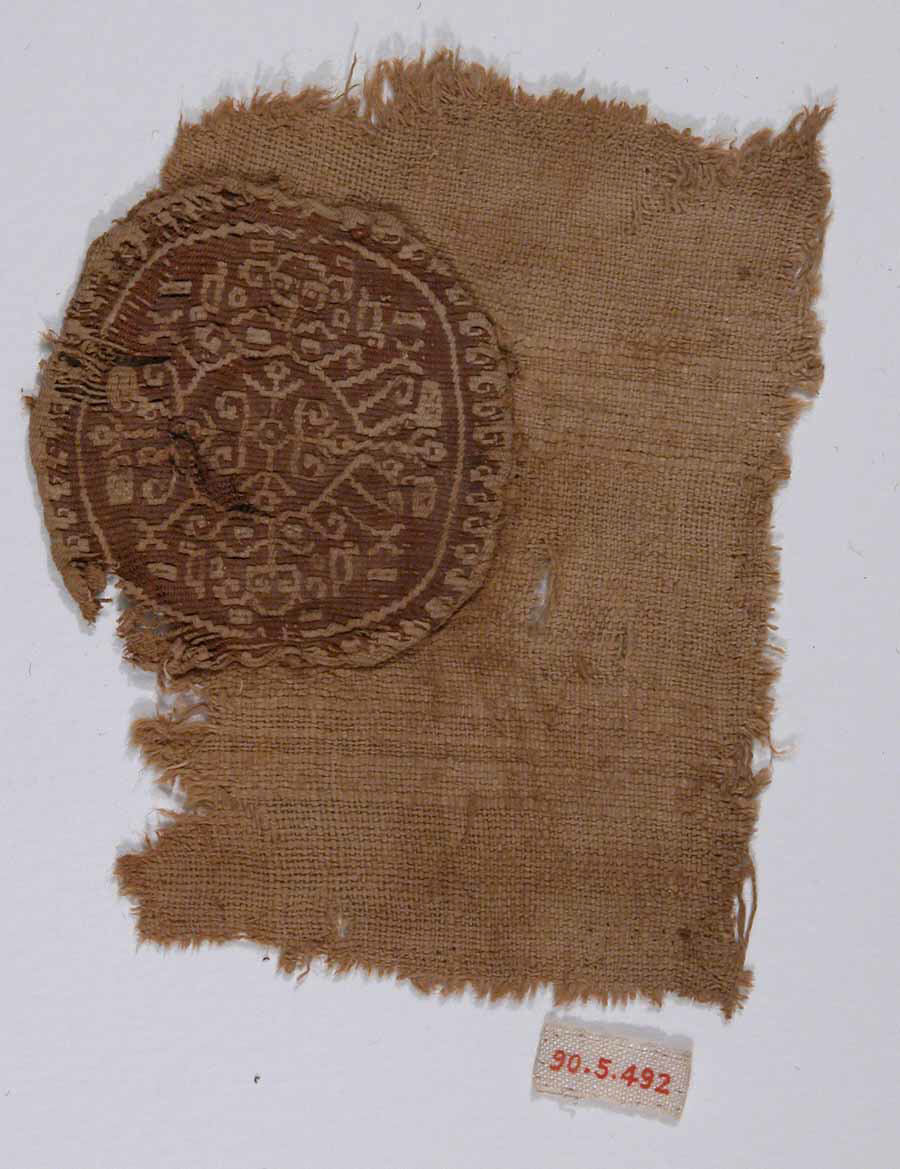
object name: textile fragment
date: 301-500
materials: linen, wool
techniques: weave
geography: egypt